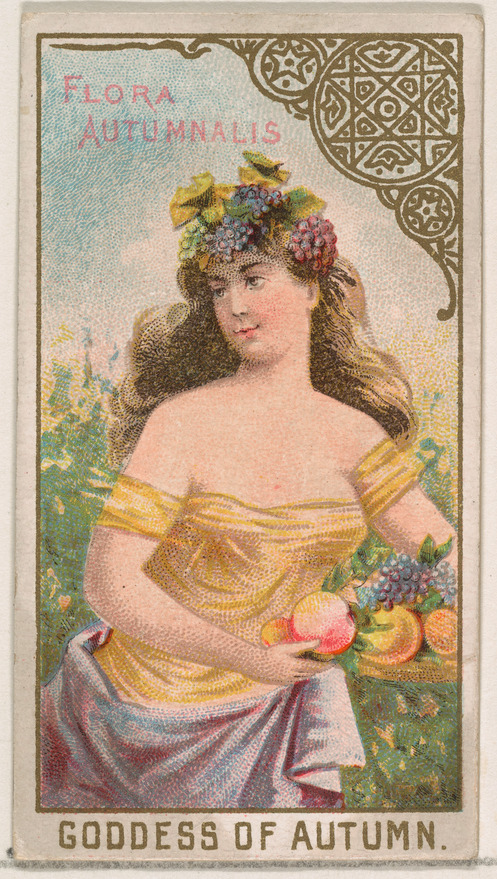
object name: print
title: Flora Autumnalis, Goddess of Autumn, from the Goddesses of the Greeks and Romans series (N188) issued by Wm. S. Kimball & Co.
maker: william s. kimball & company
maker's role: publisher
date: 1889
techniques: color lithograph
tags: fruit,women,goddess